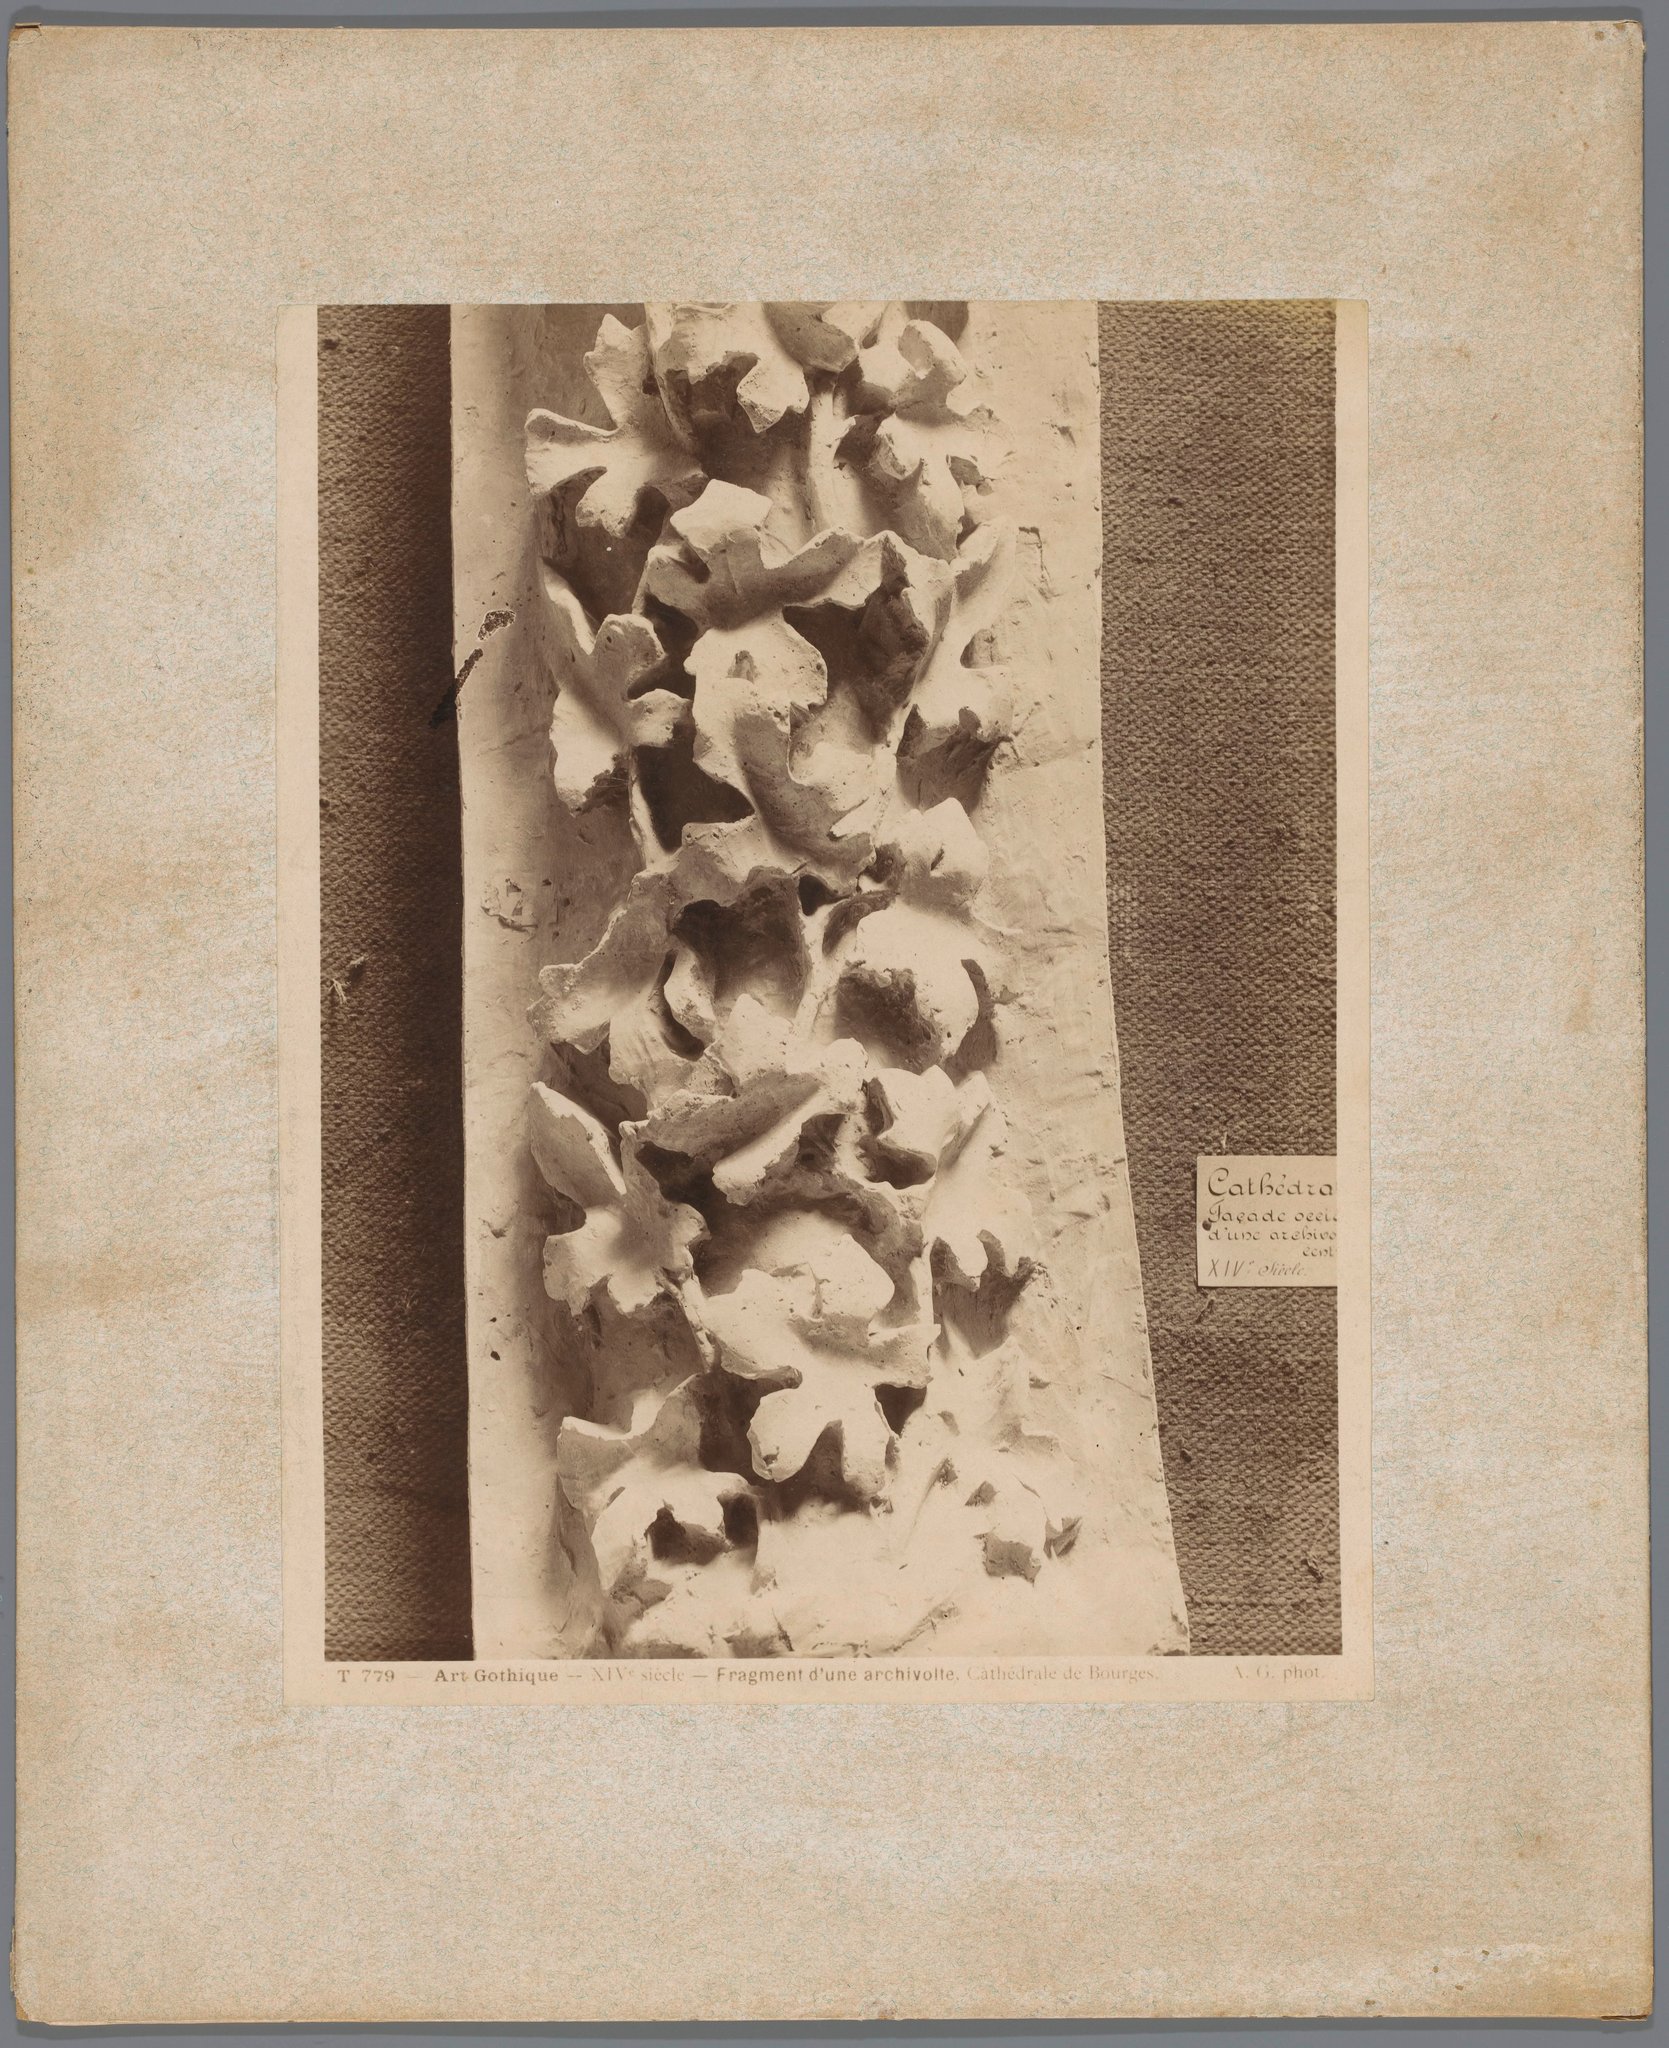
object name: photograph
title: Art Gothique XIVe siècle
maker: Anonymous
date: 1850-1900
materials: cardboard, photographic support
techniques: albumen print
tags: arch, archivolt ~ architecture, piece of sculpture, reproduction of a piece of sculpture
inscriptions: collector's mark: ‘Rijks-normaalschool voor teekenonderwijzers amsterdam’, inscription: ‘Cathédrale de Bourges. A.G. phot.’, number: ‘T 779’